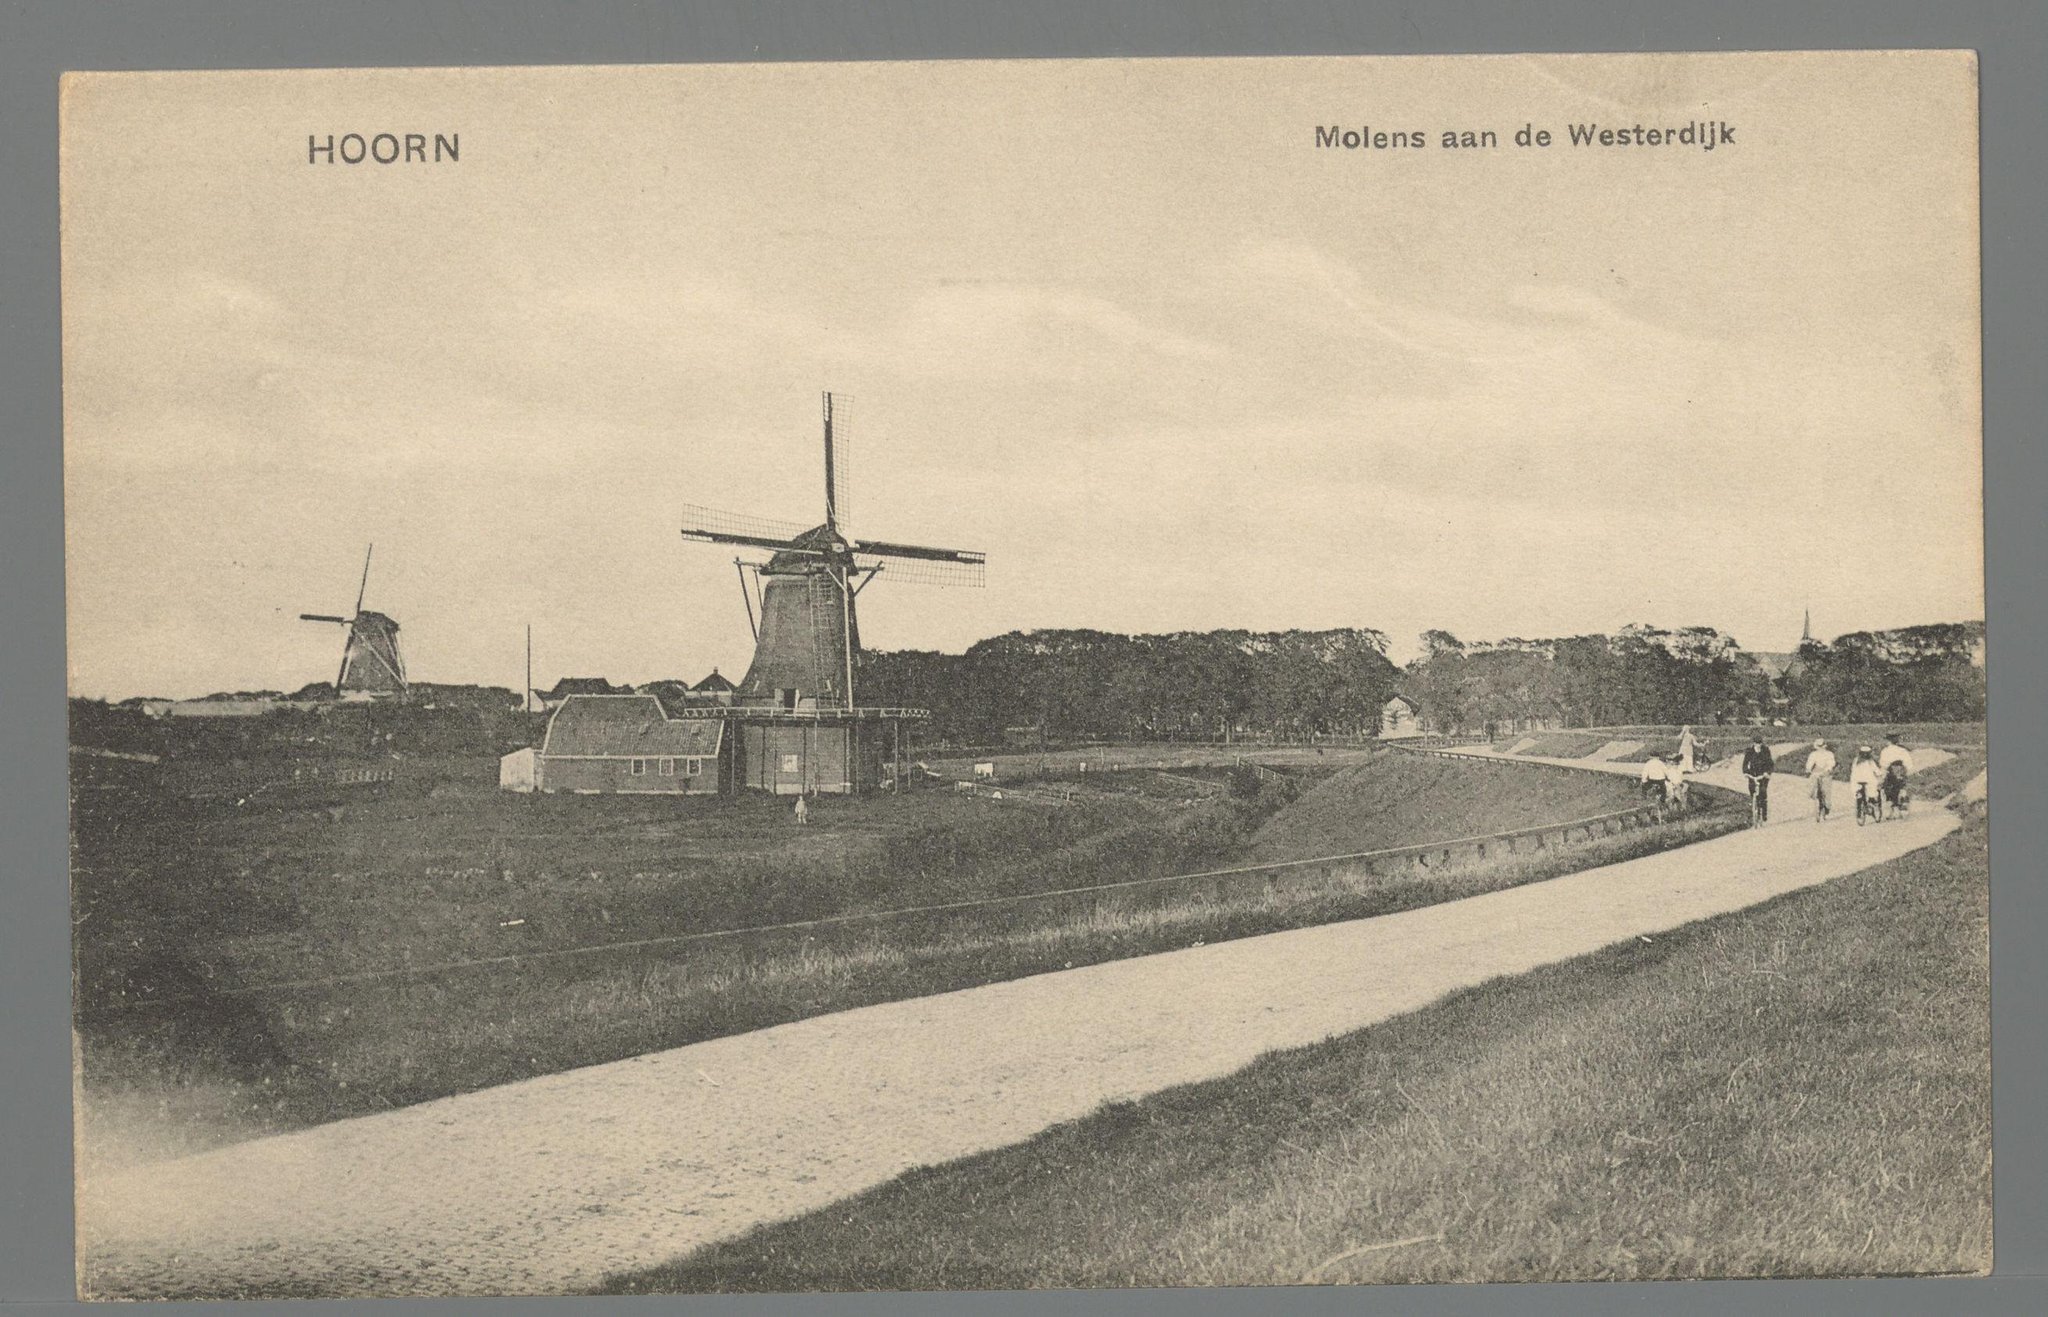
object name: photomechanical print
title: Hoorn. Molens aan de Westerdijk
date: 1906-1930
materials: cardboard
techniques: photograph, writing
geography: hoorn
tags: landscapes in the temperate zone, windmill in landscape, dikes, levee, hoorn (north holland)